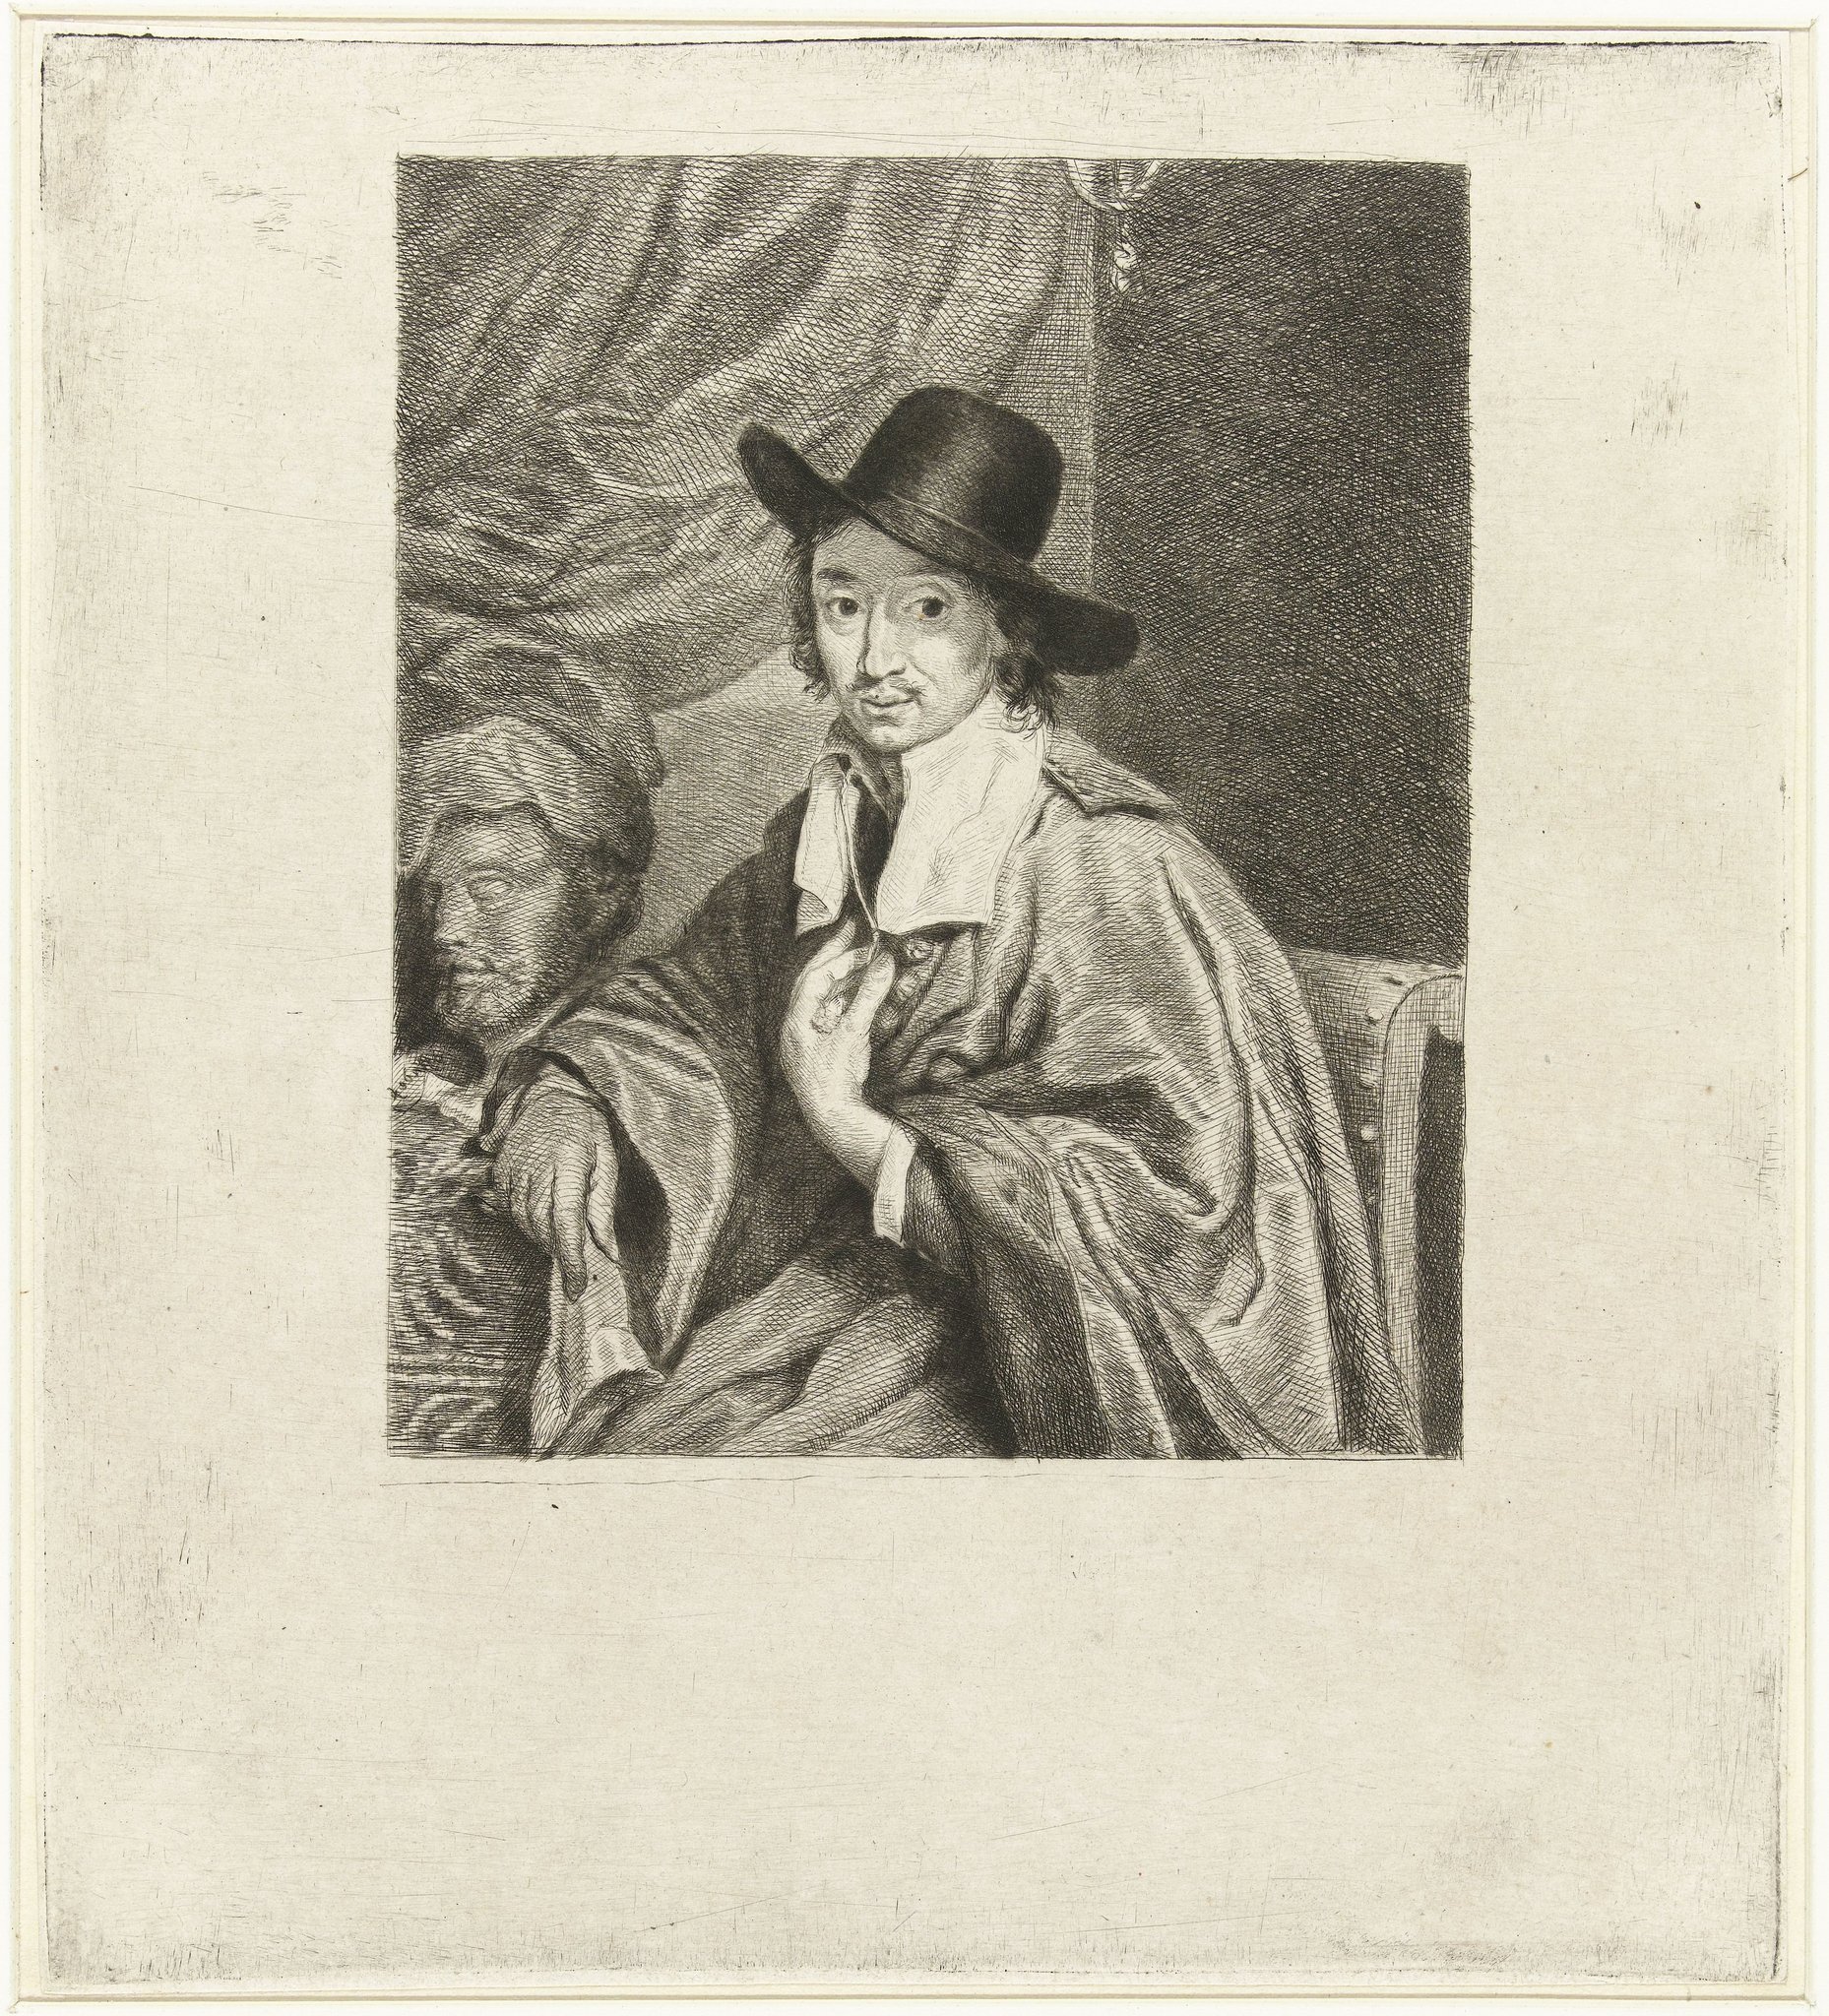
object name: print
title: Portret van de schilder Adriaen van Ostade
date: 1756-1817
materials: paper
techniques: drypoint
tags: painter, print maker, draughtsman, adriaen van ostade, portrait, self-portrait of artist (+ artist in non-work situation)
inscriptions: collector's mark: Lugt 2228